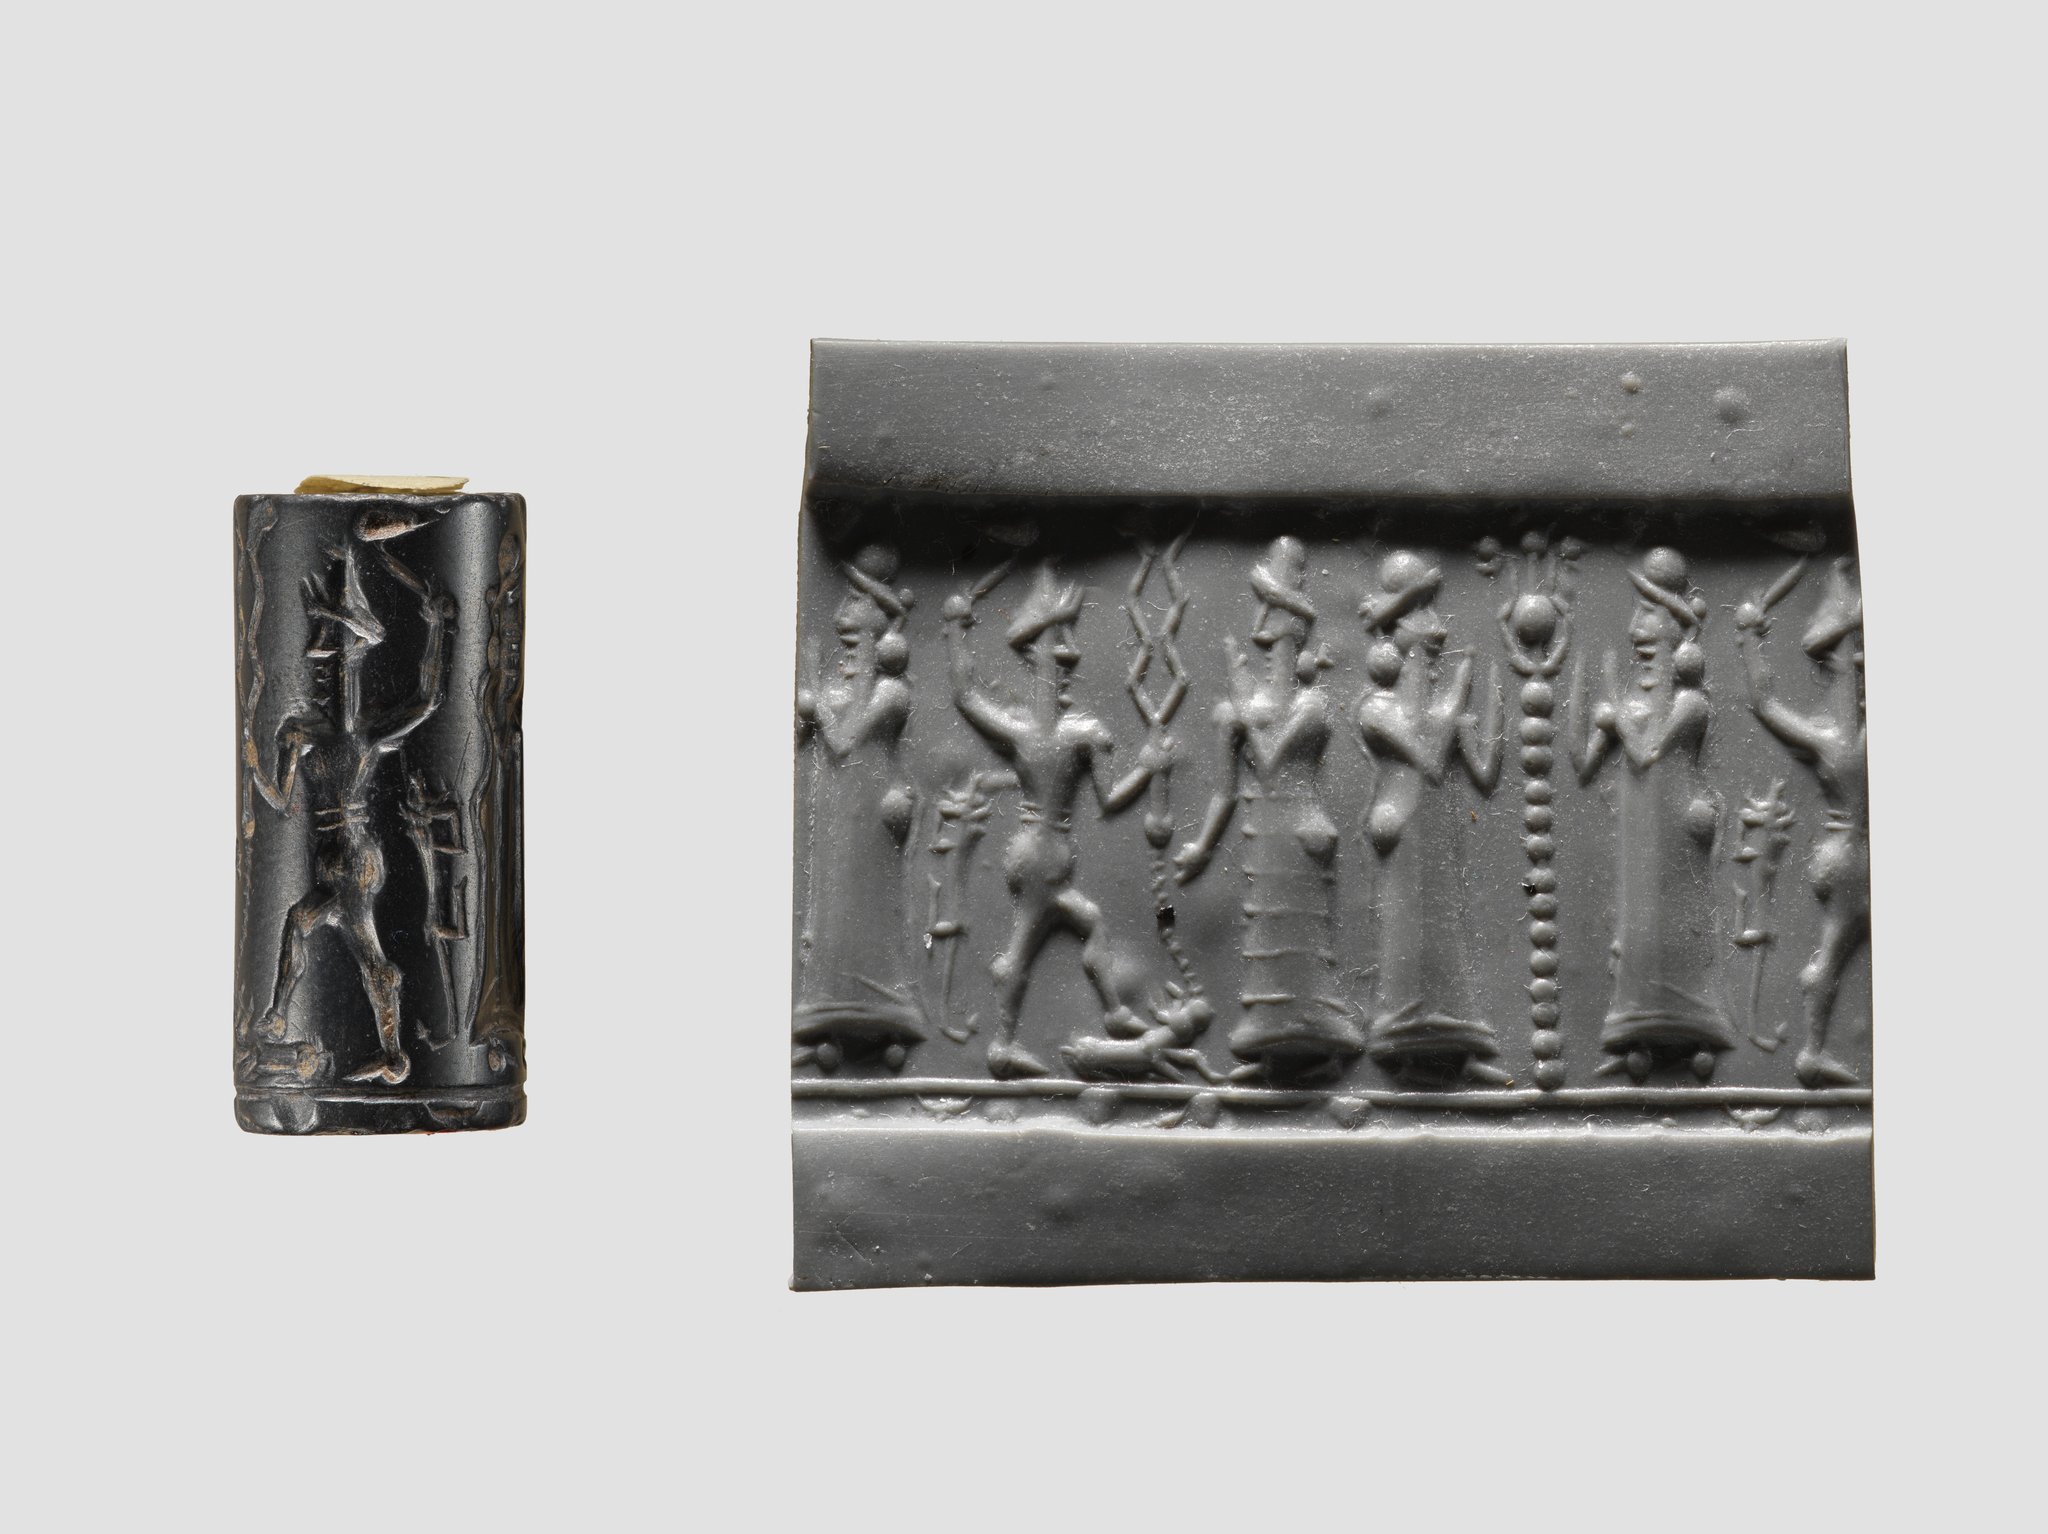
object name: cylinder seal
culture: babylonian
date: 2000-1668 BCE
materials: mineral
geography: mesopotamia